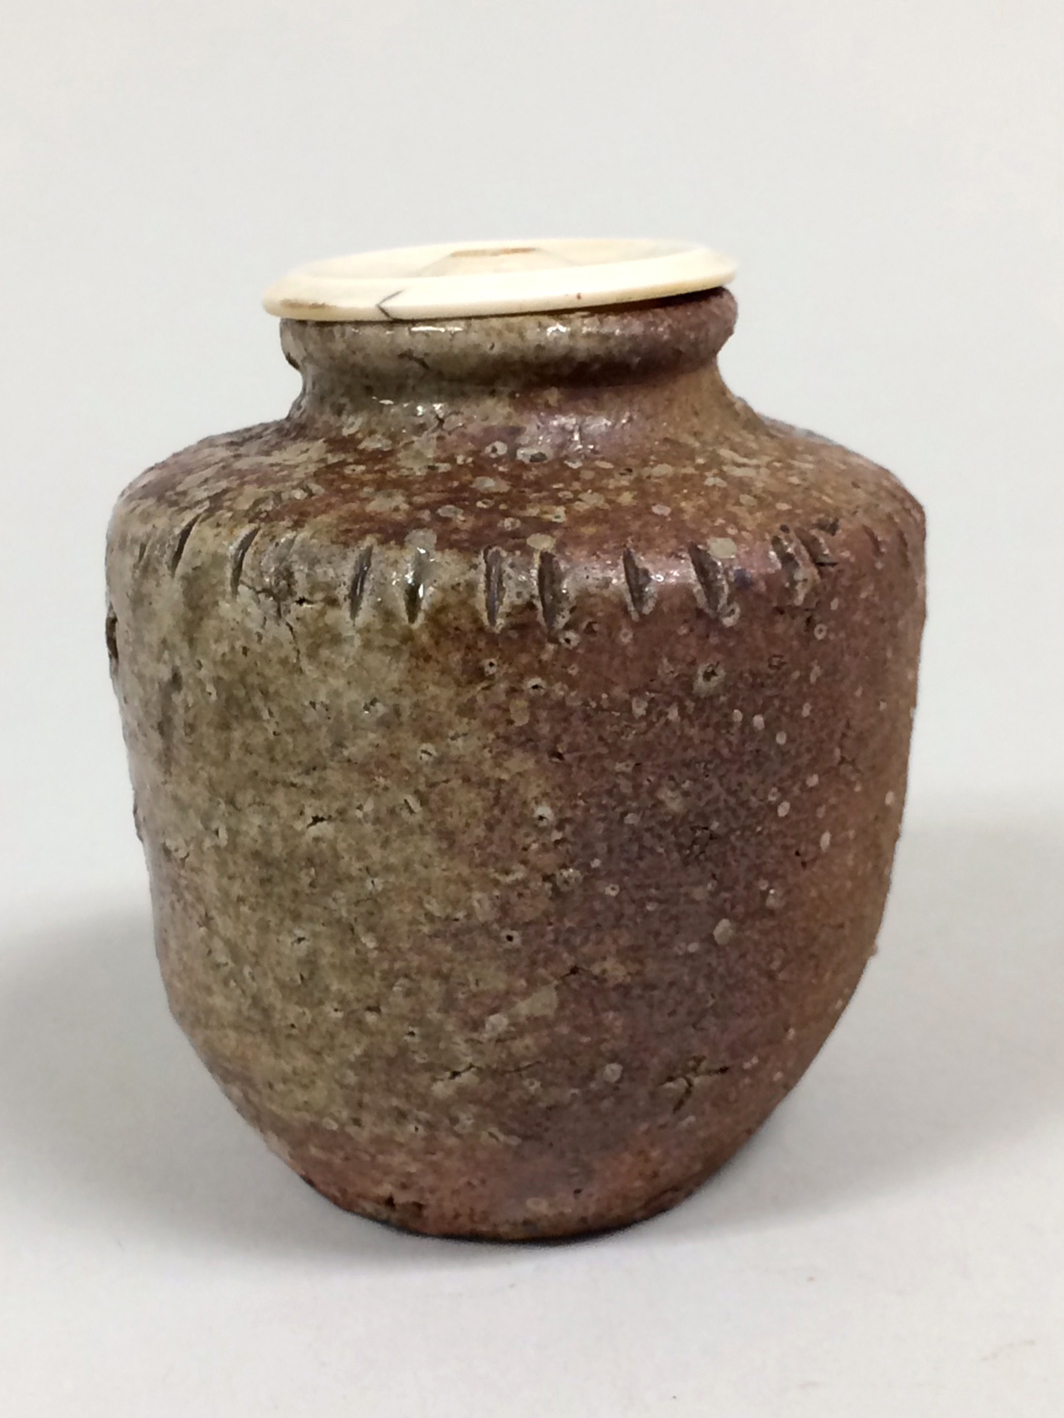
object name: tea jar with cover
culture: japanese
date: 1745